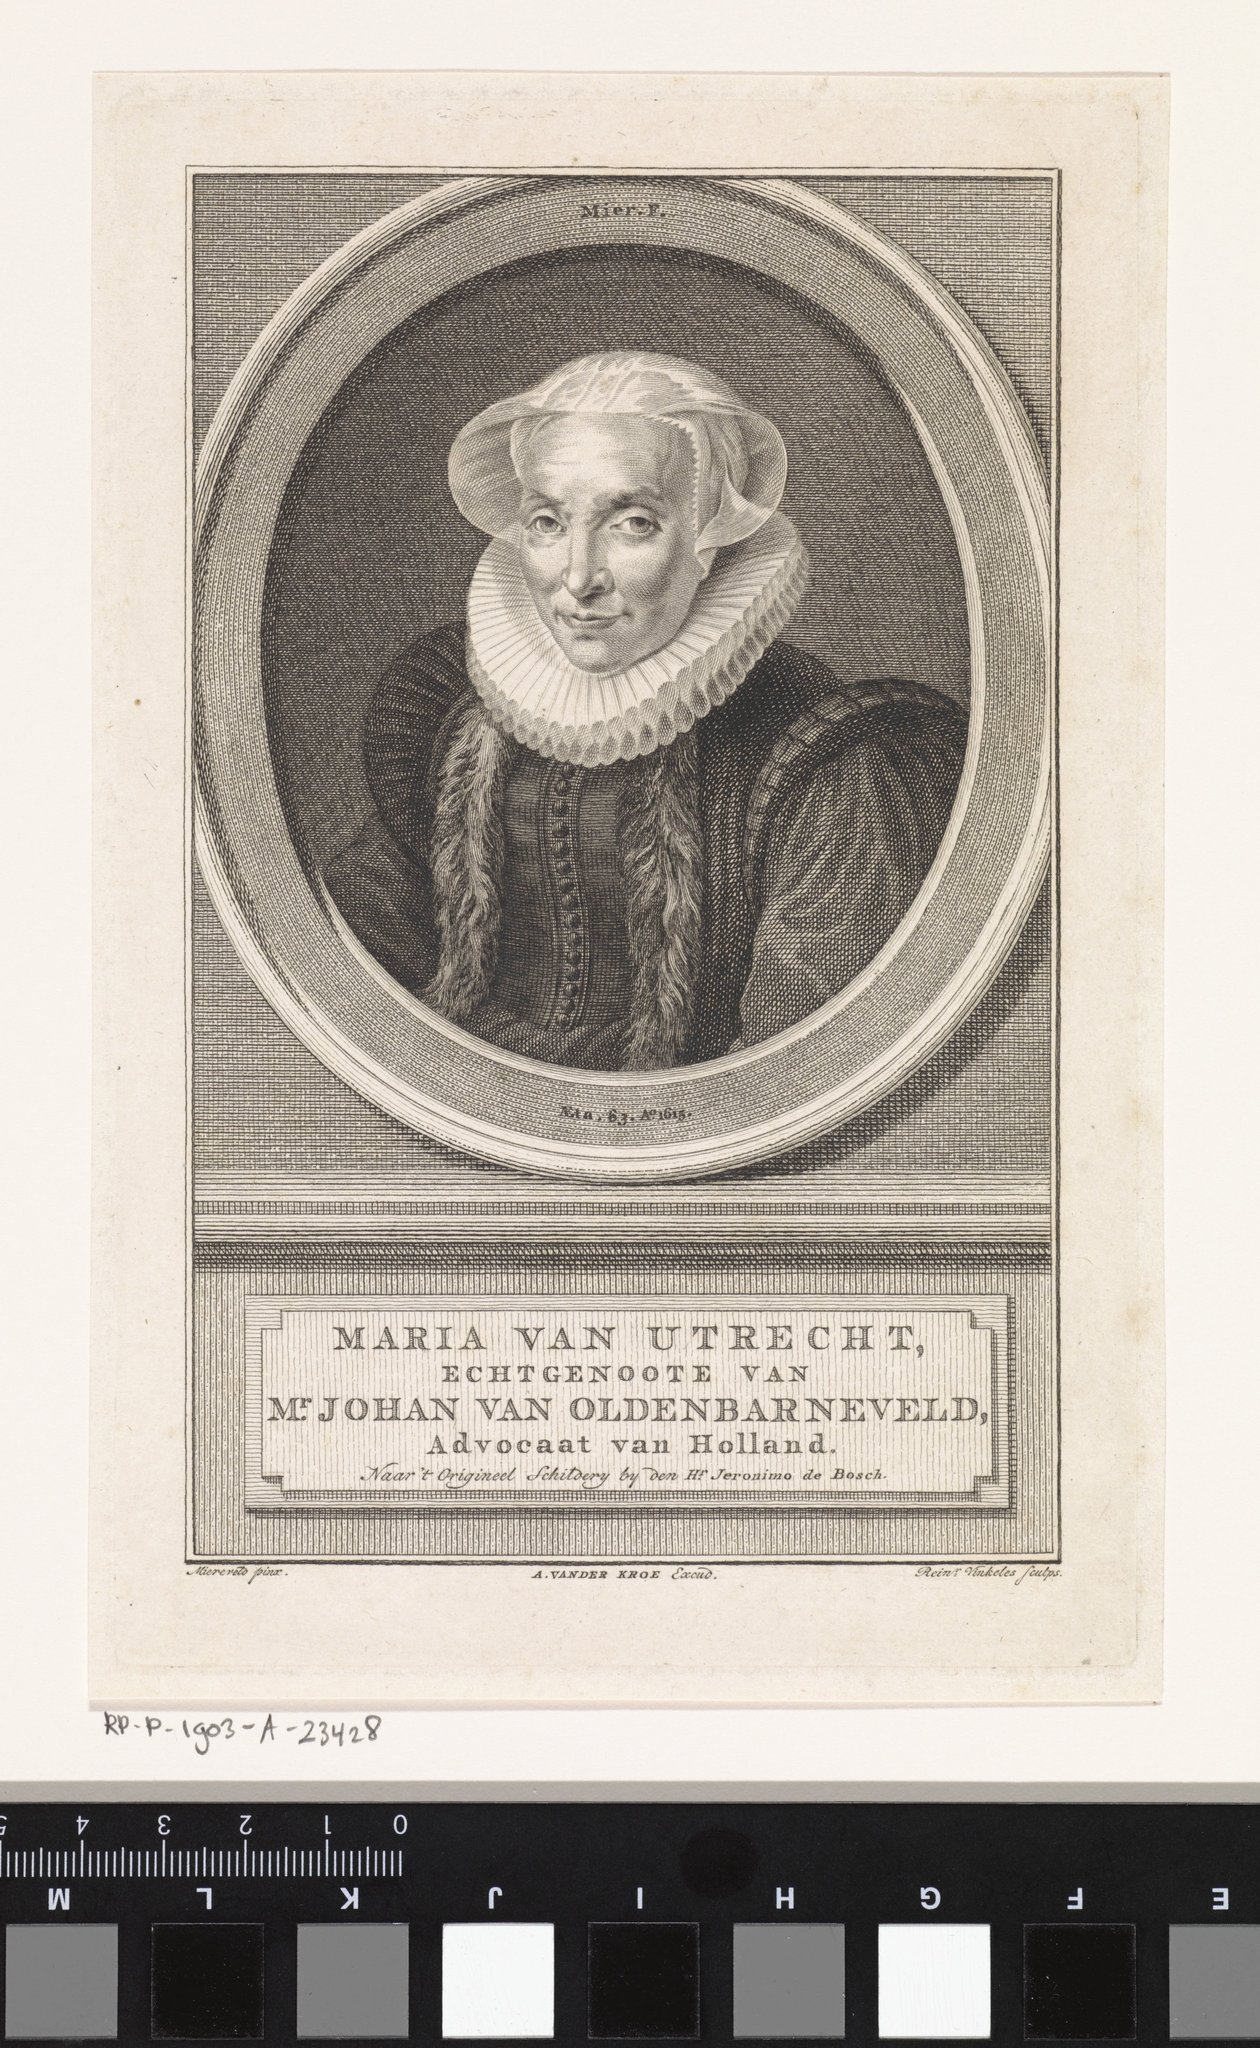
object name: print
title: Portret van Maria van Utrecht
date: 1758-1816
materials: paper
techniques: engraving, etching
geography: amsterdam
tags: maria van utrecht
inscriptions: collector's mark: Lugt 2228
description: Portret van Maria van Utrecht, echtgenote van Johan van Oldenbarnevelt, op 63-jarige leeftijd.